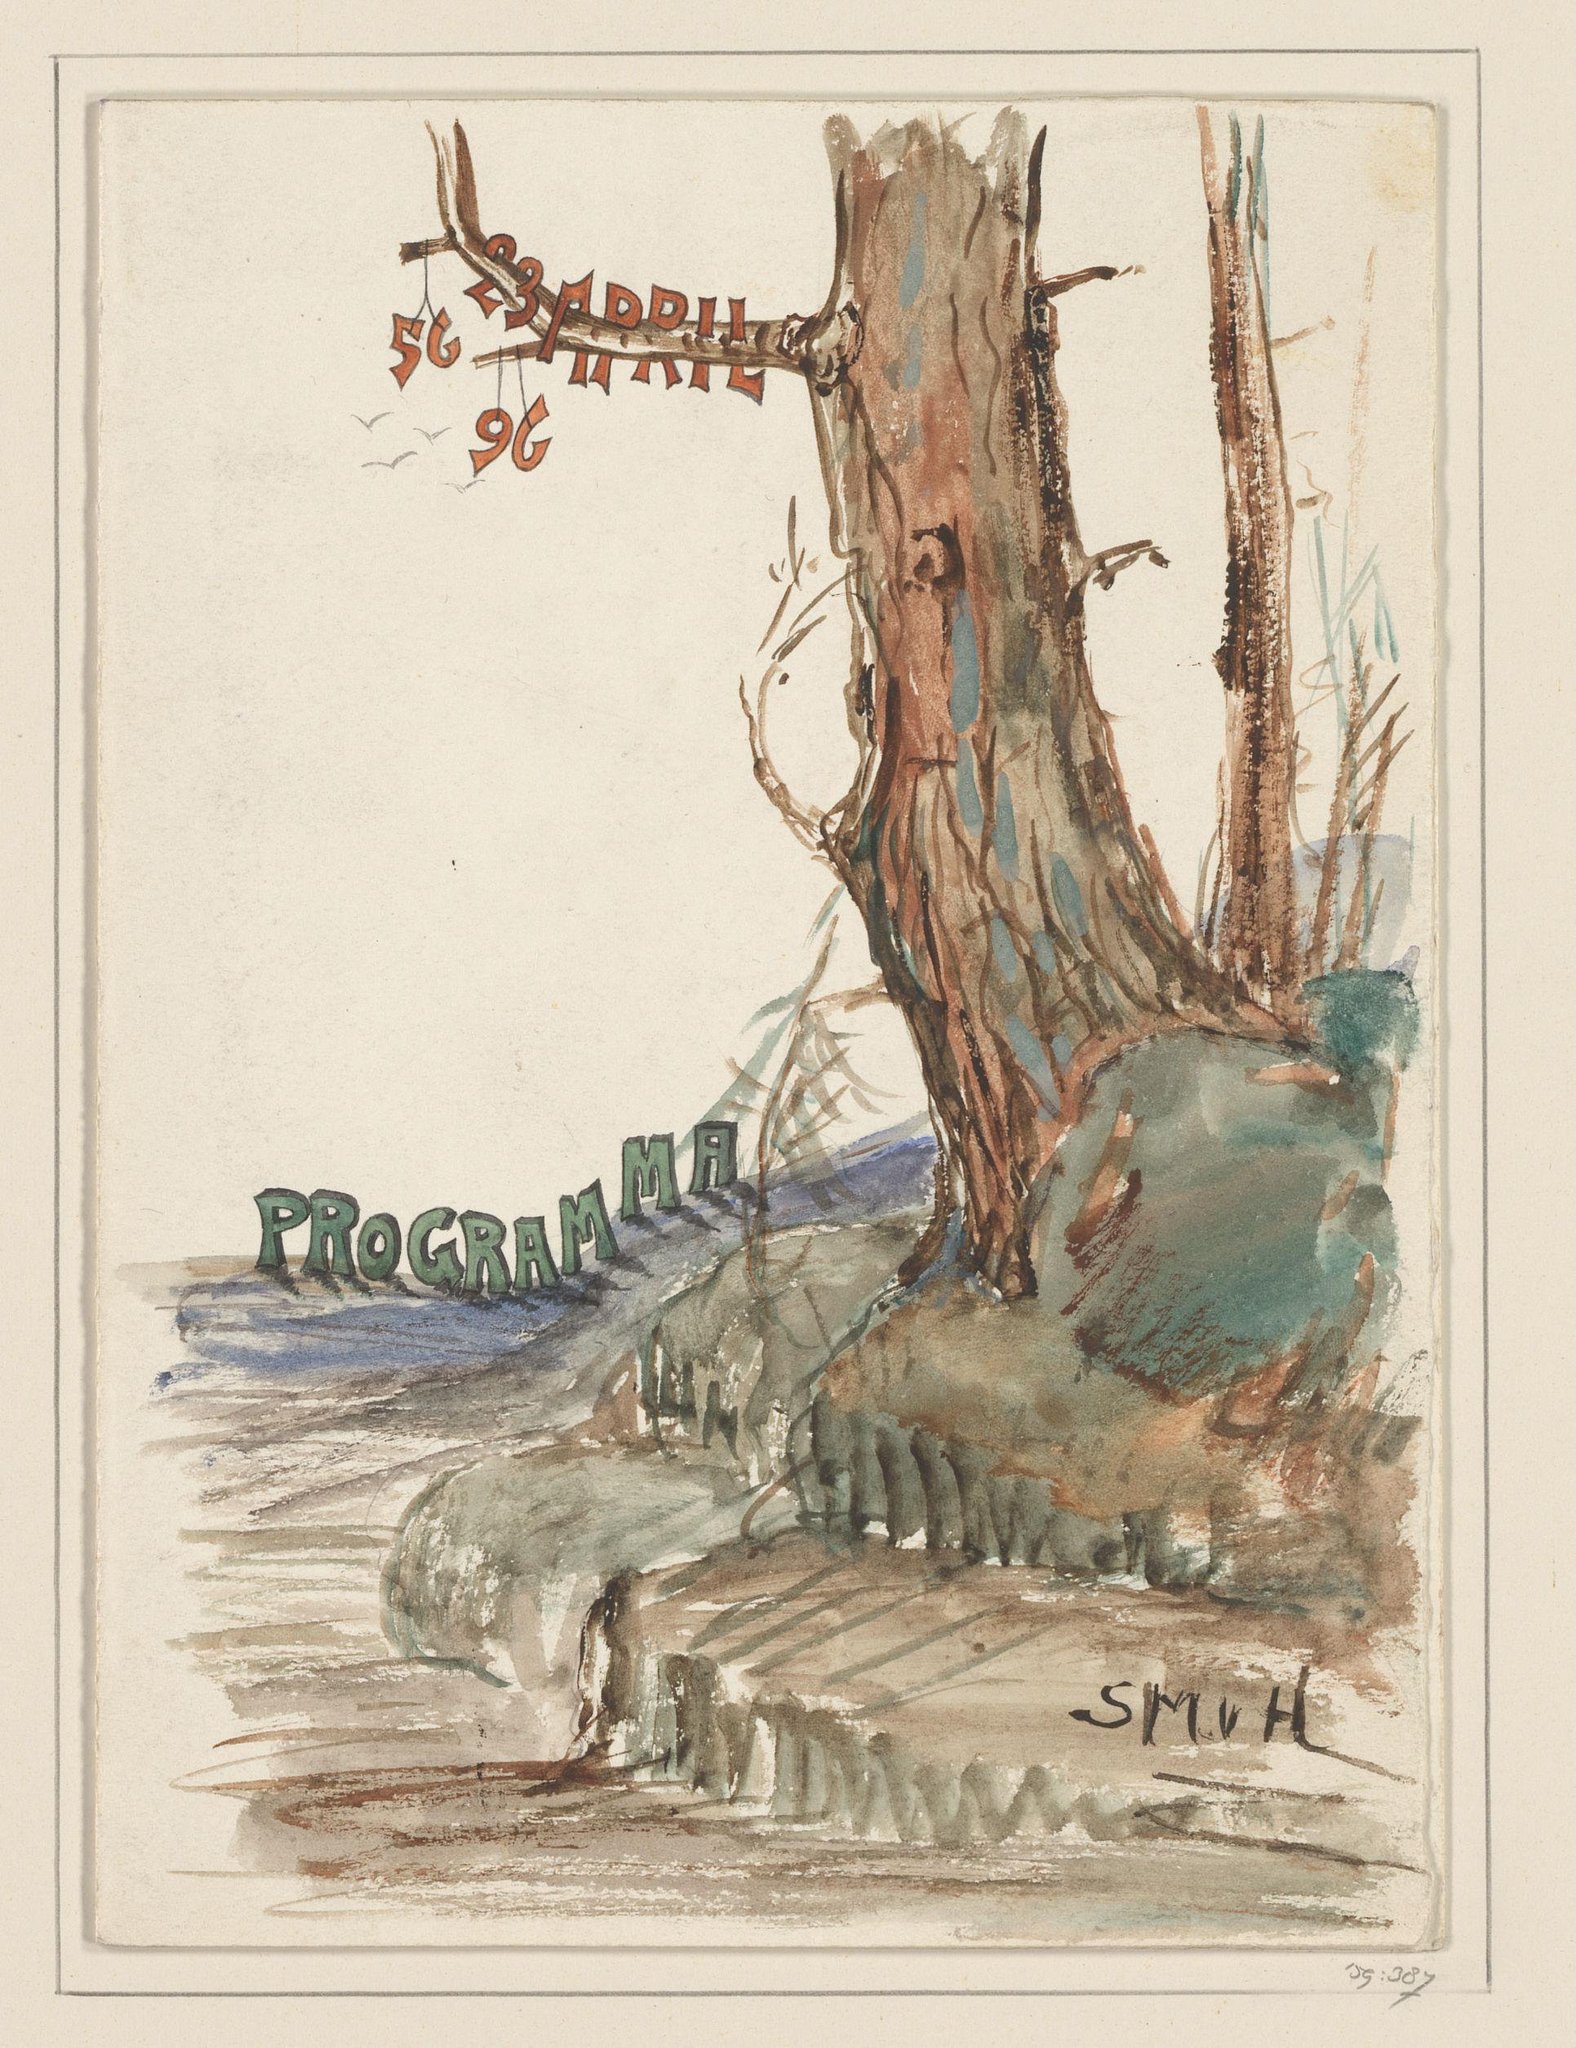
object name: drawing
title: Uitnodiging met een boom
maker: sientje mesdag-van houten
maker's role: draughtsman, painter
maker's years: 1834-1909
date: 1896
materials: paper, pencil, watercolor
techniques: brush, pen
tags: trees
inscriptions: date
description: Uitnodiging voor een balletvoorstelling op 23 april 1896, met binnenin het programma van het 'ballet des pierrots et pierrettes'.